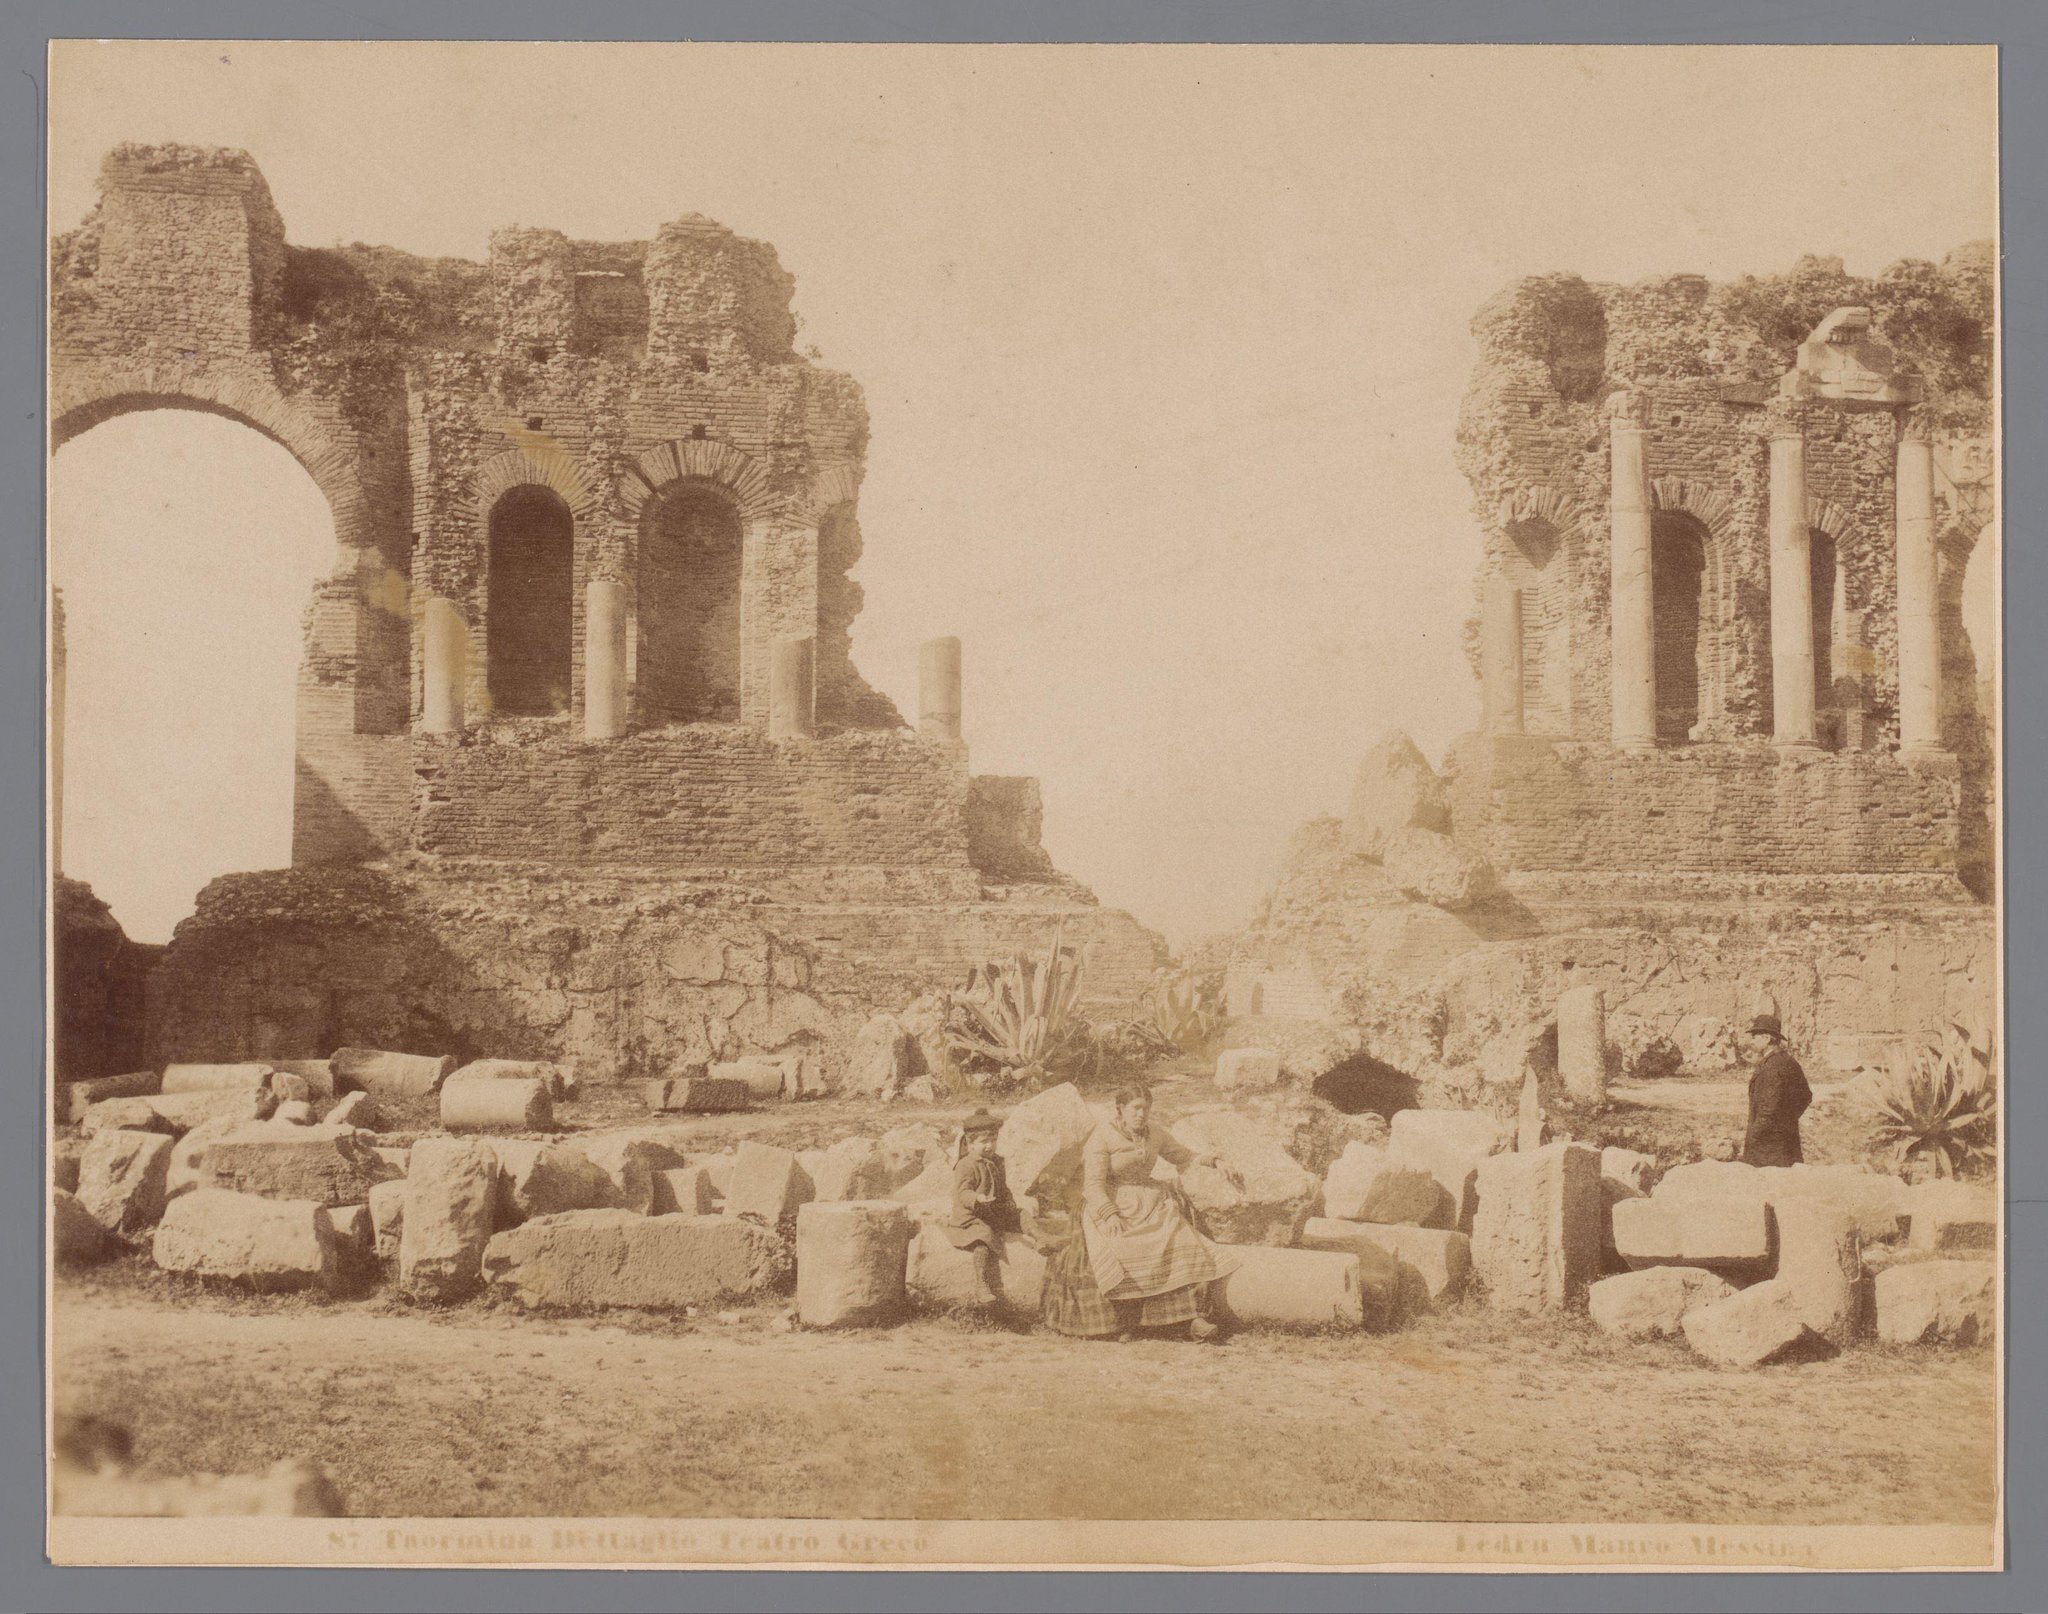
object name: photograph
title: Taormina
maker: ledru mauro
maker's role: fotograaf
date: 1880-1900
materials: cardboard, paper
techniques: albumen print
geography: taormina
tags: ruin of a building ~ architecture, amphitheatre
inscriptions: number: ‘87’